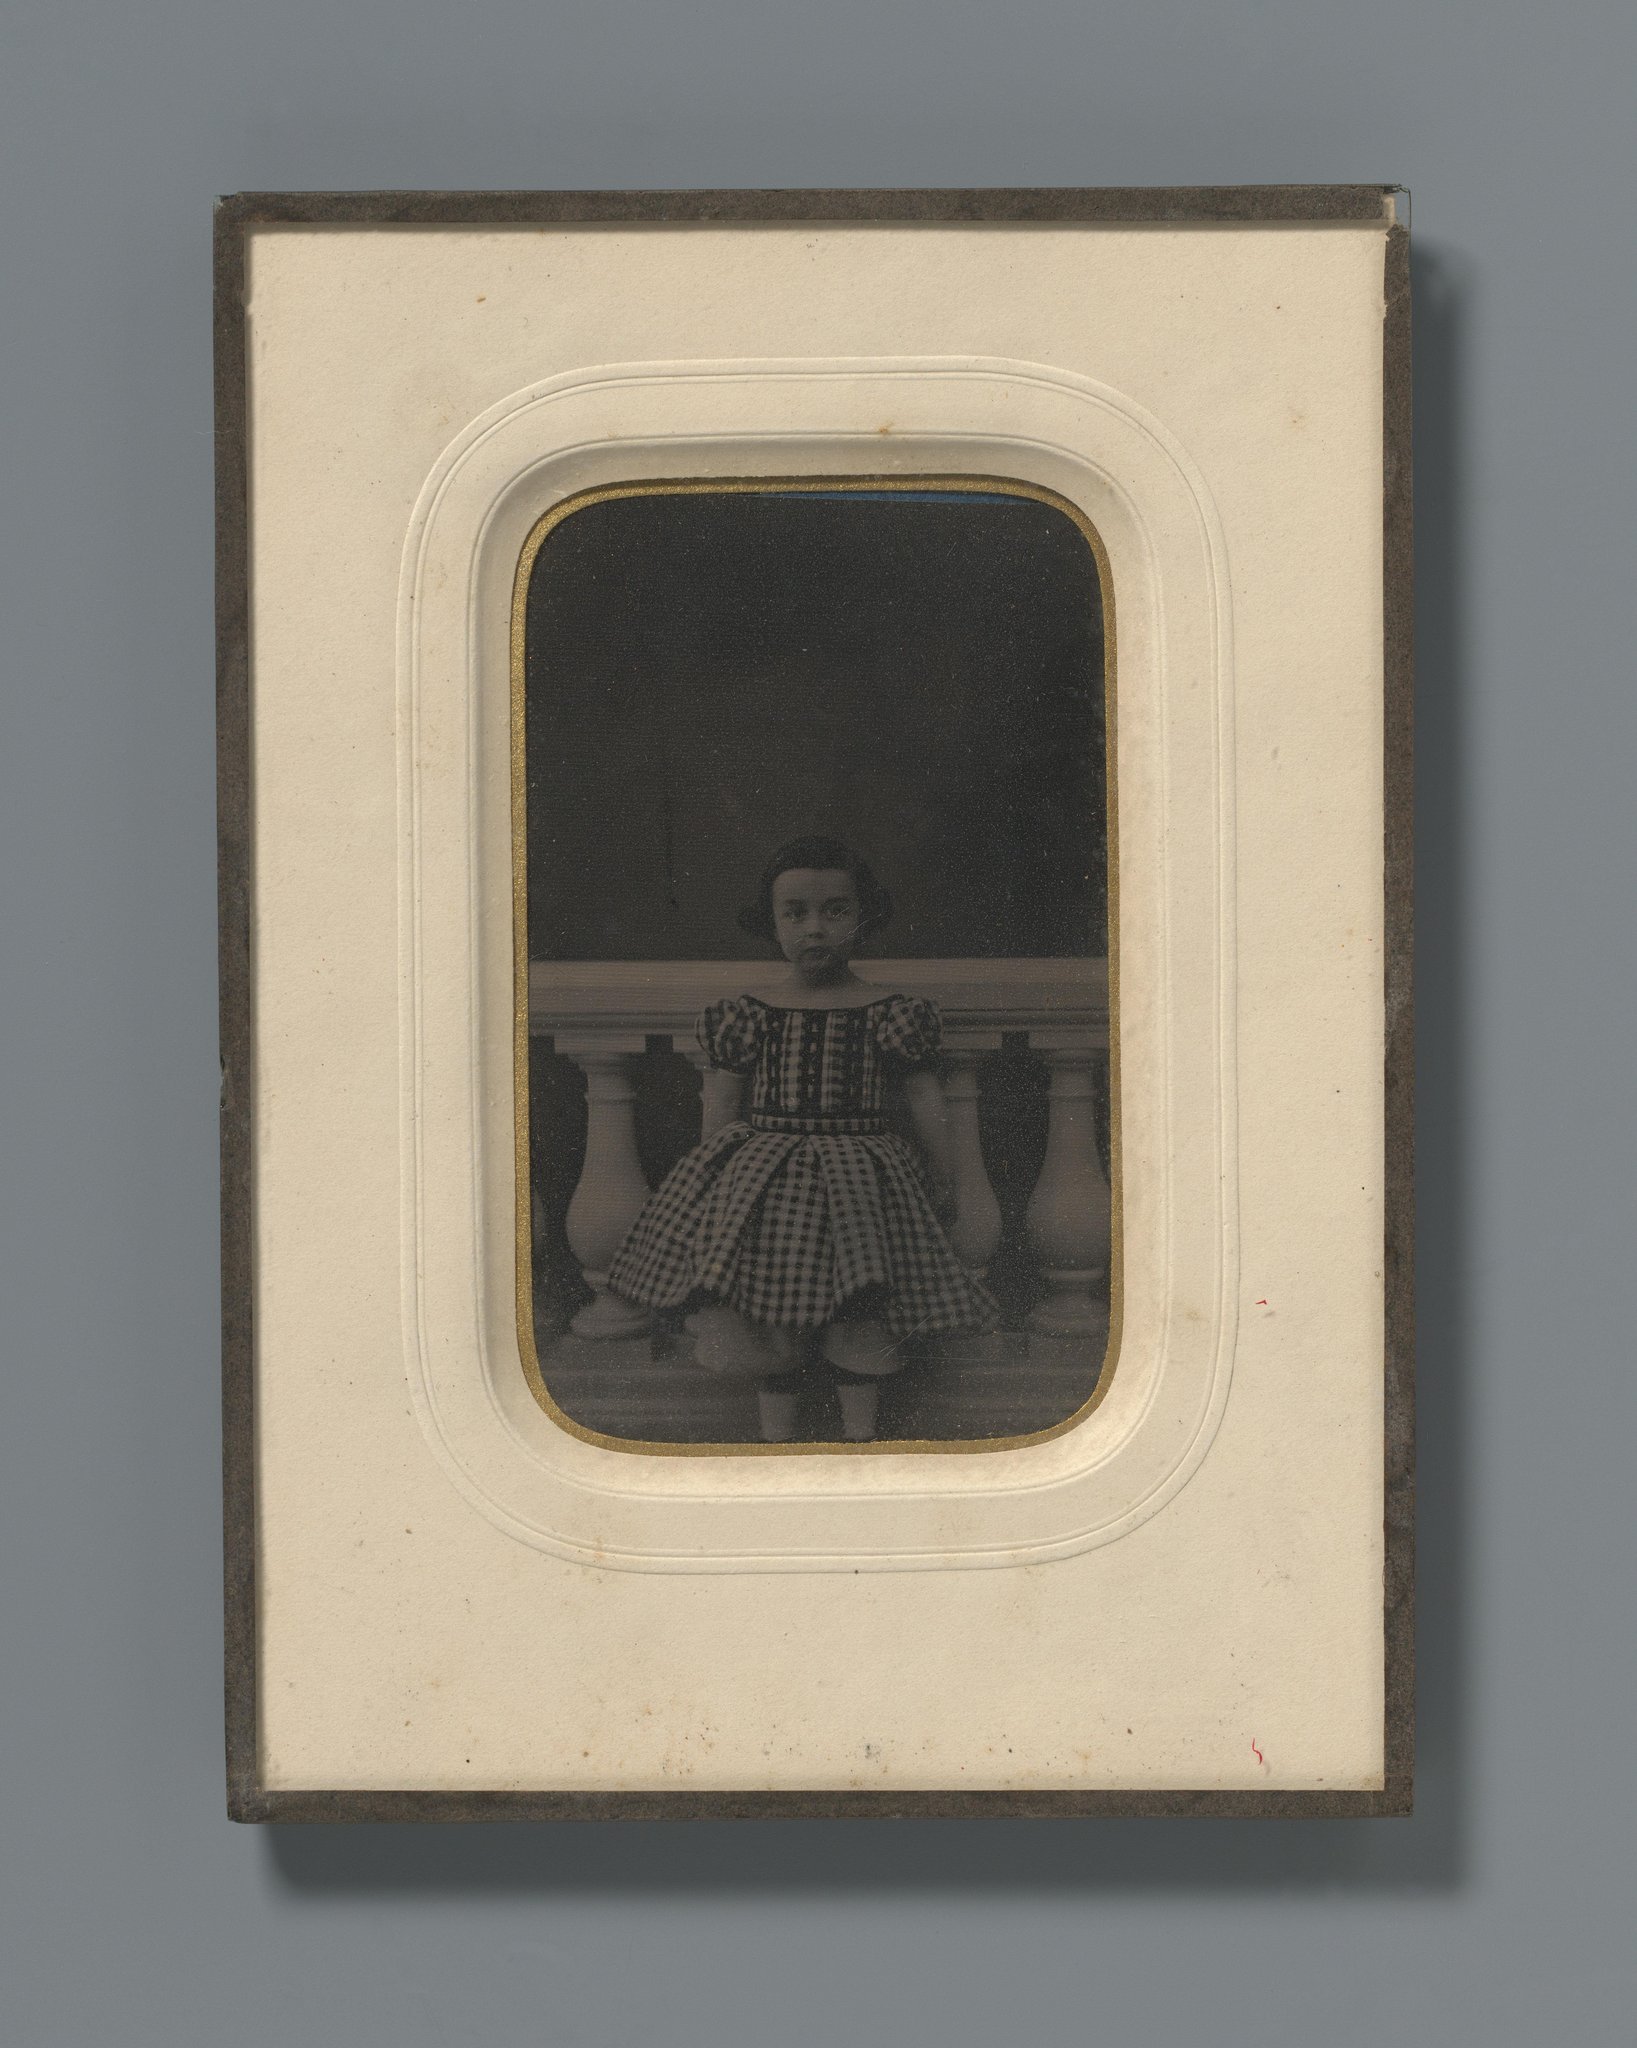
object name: frame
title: Portret van een onbekend meisje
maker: Anonymous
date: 1859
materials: canvas, cardboard, metal, paper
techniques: pannotype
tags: historical persons - bb - woman, child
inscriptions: annotation: ‘1859/ H[ea]th[er] [...]’